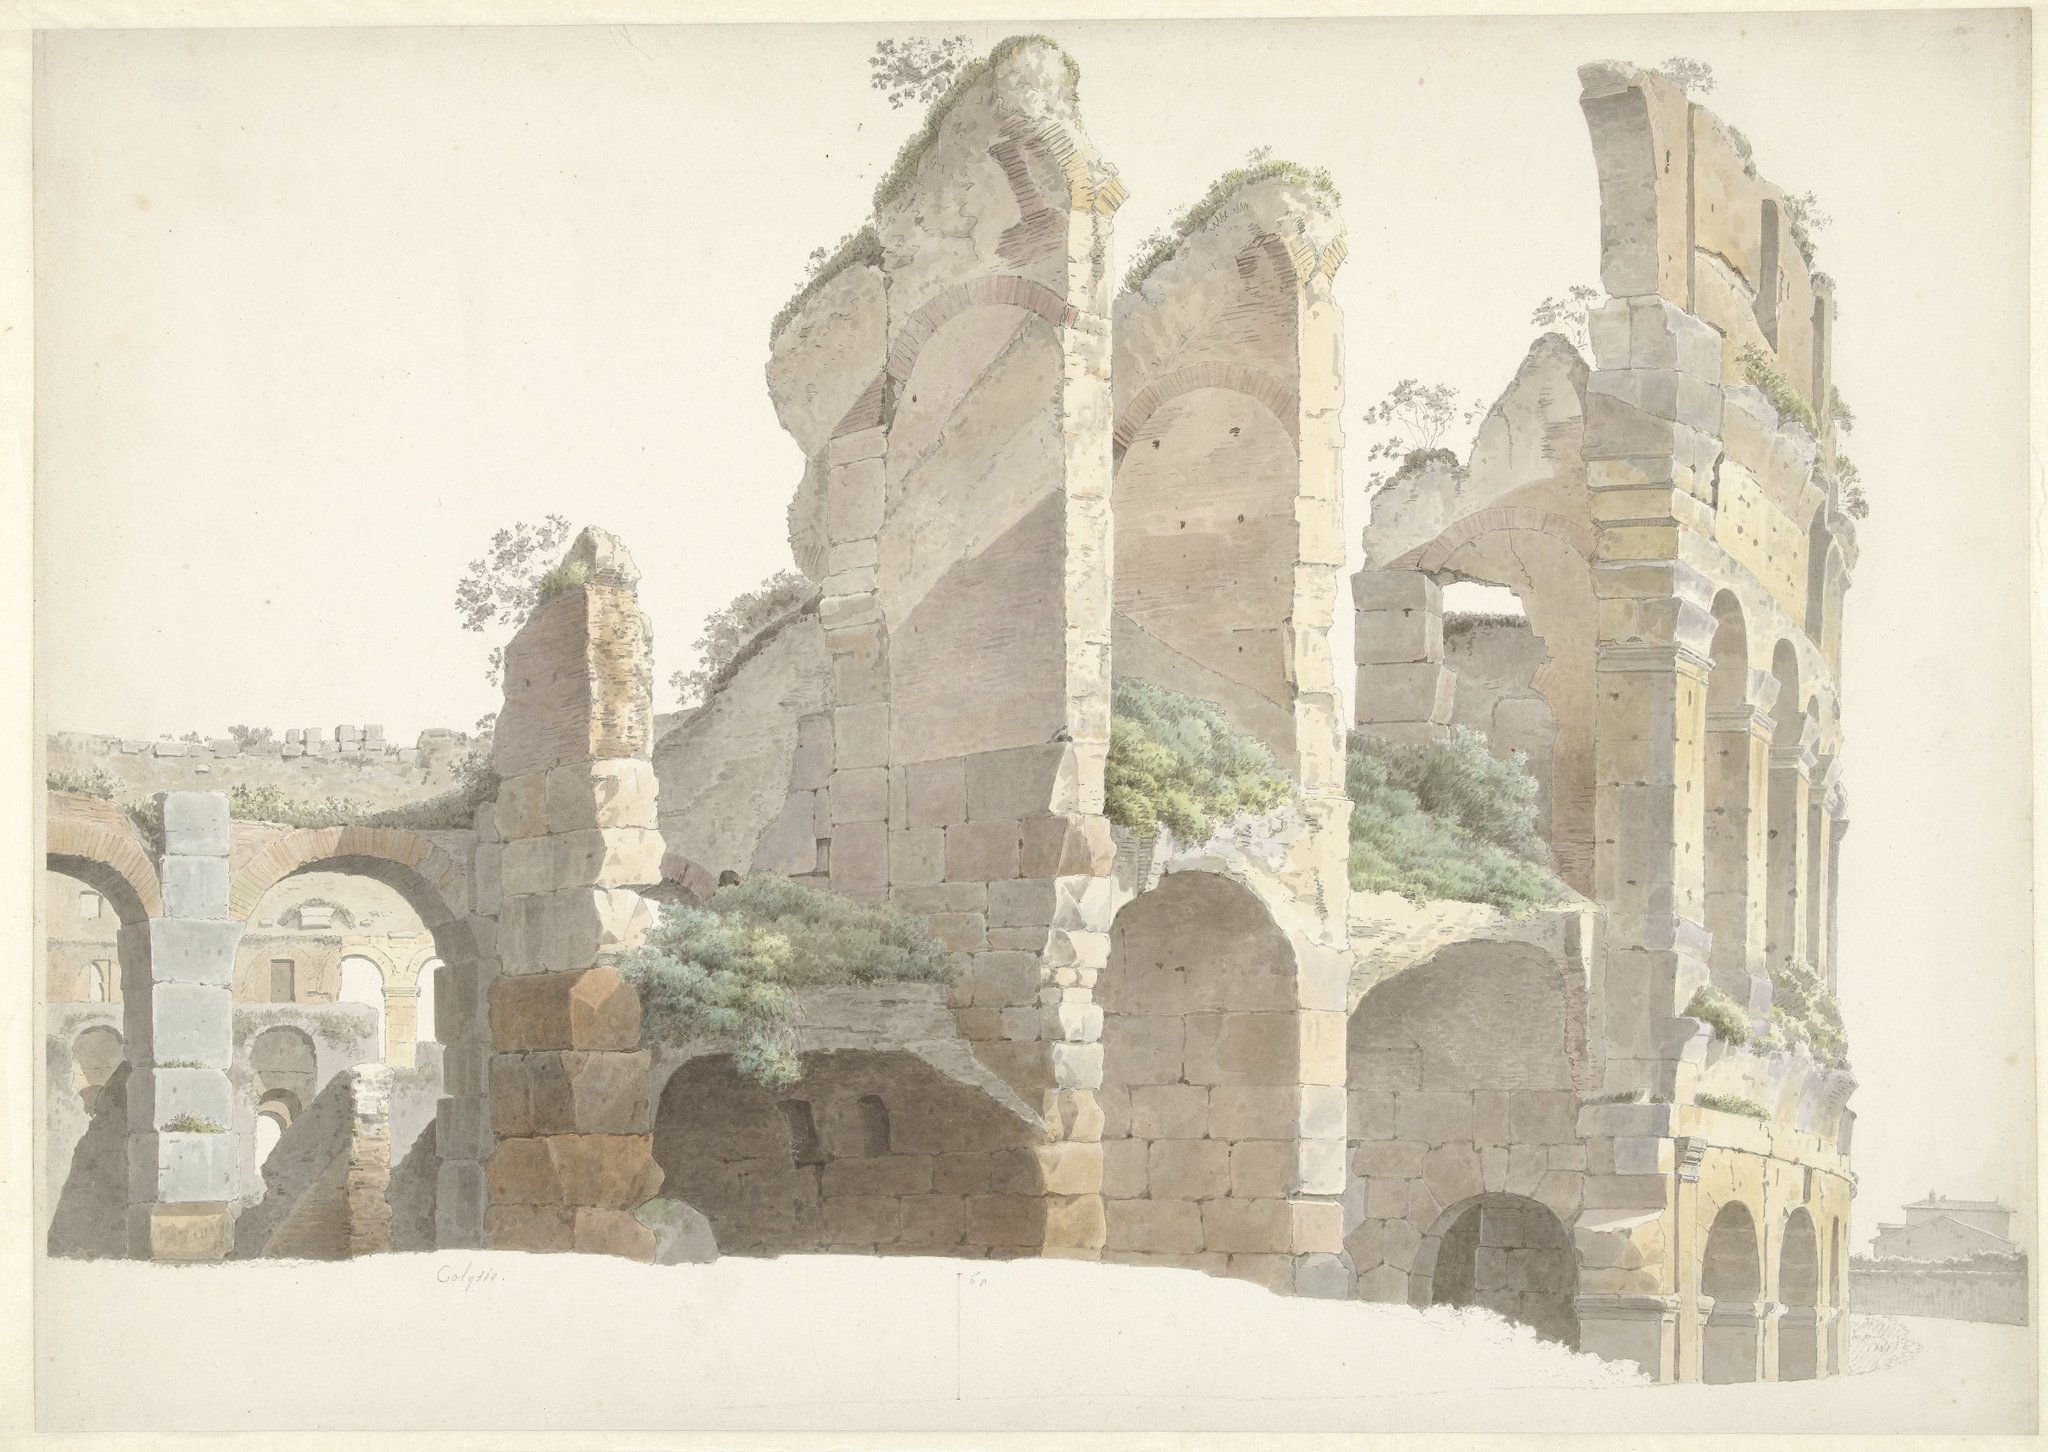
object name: watercolor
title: Het Colosseum te Rome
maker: josephus augustus knip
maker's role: draughtsman, painter, print maker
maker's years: 1777-1847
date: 1809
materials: paper, pencil, watercolor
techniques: brush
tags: ruin of a building ~ architecture